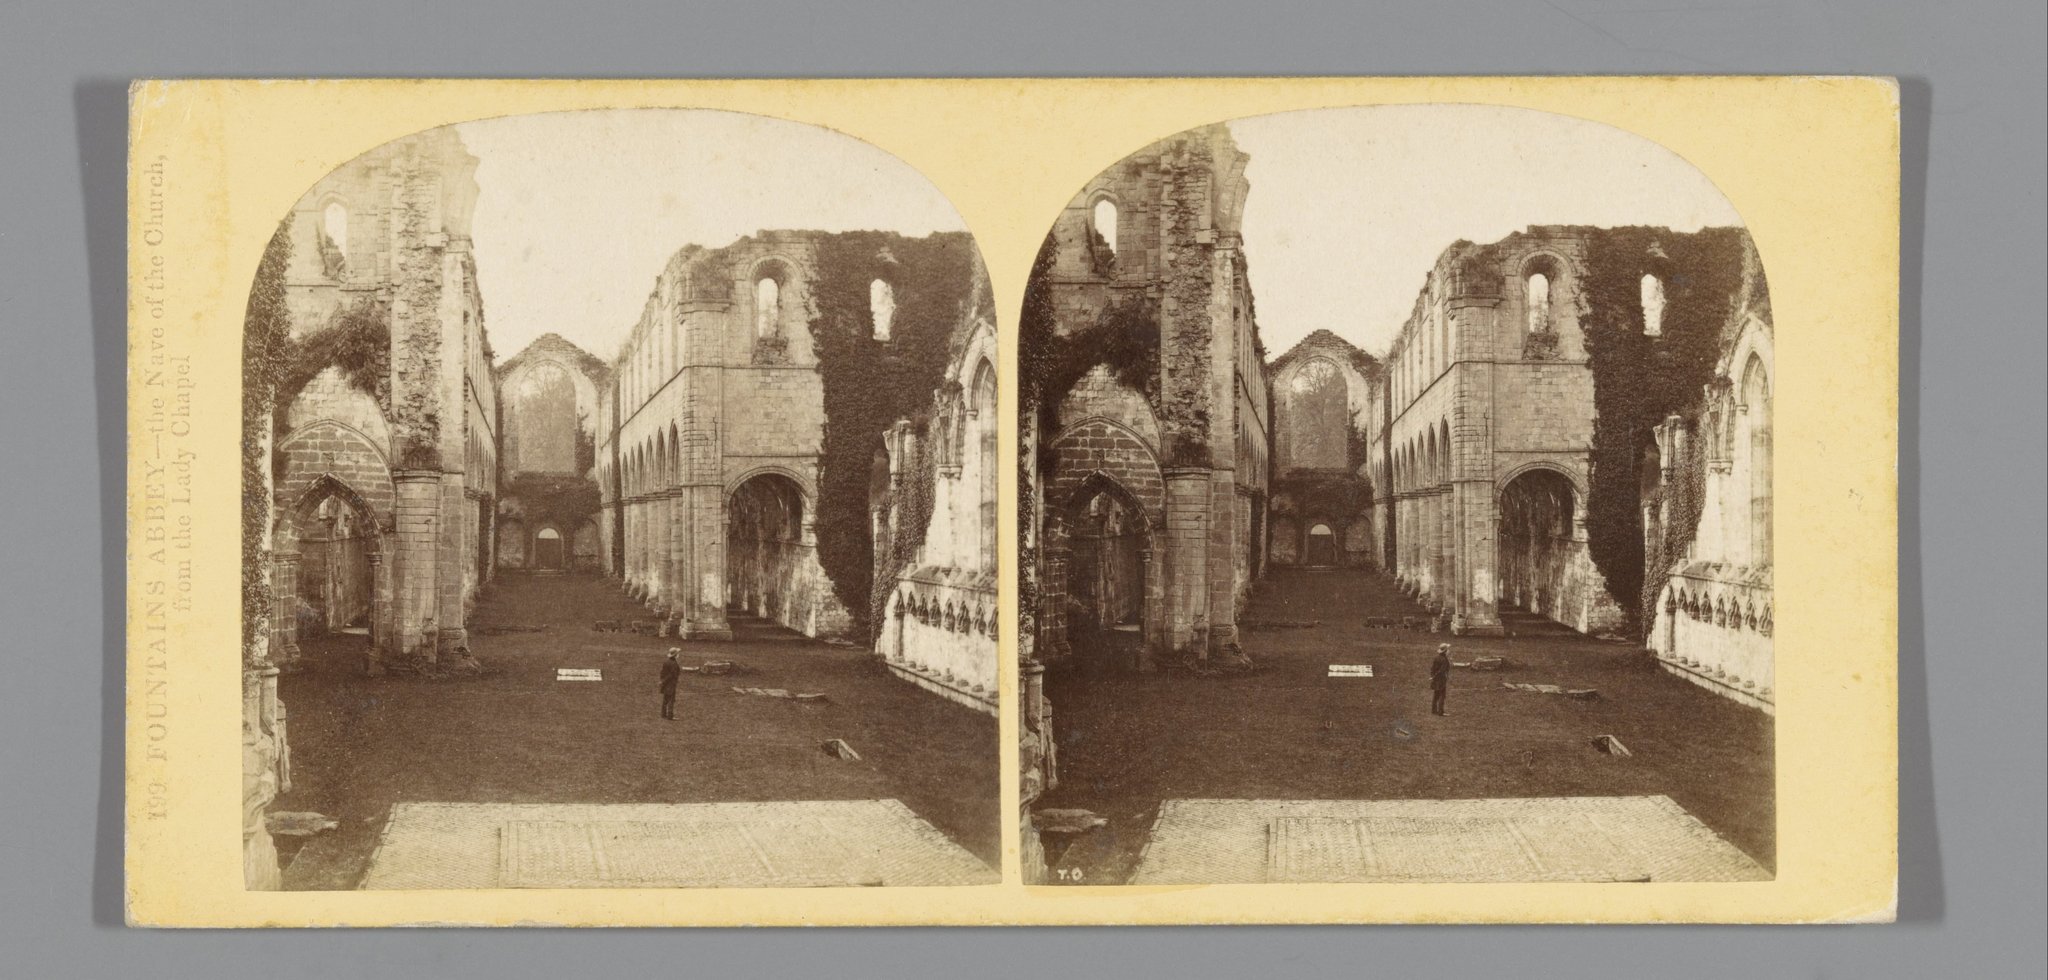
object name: stereograph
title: Fountains Abbey-the Nave of the Church, from the Lady Chapel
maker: Anonymous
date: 1850-1880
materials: cardboard, photographic support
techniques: albumen print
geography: fountains abbey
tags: ruin of church, monastery, etc., parts of church interior: nave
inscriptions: number: ‘199’